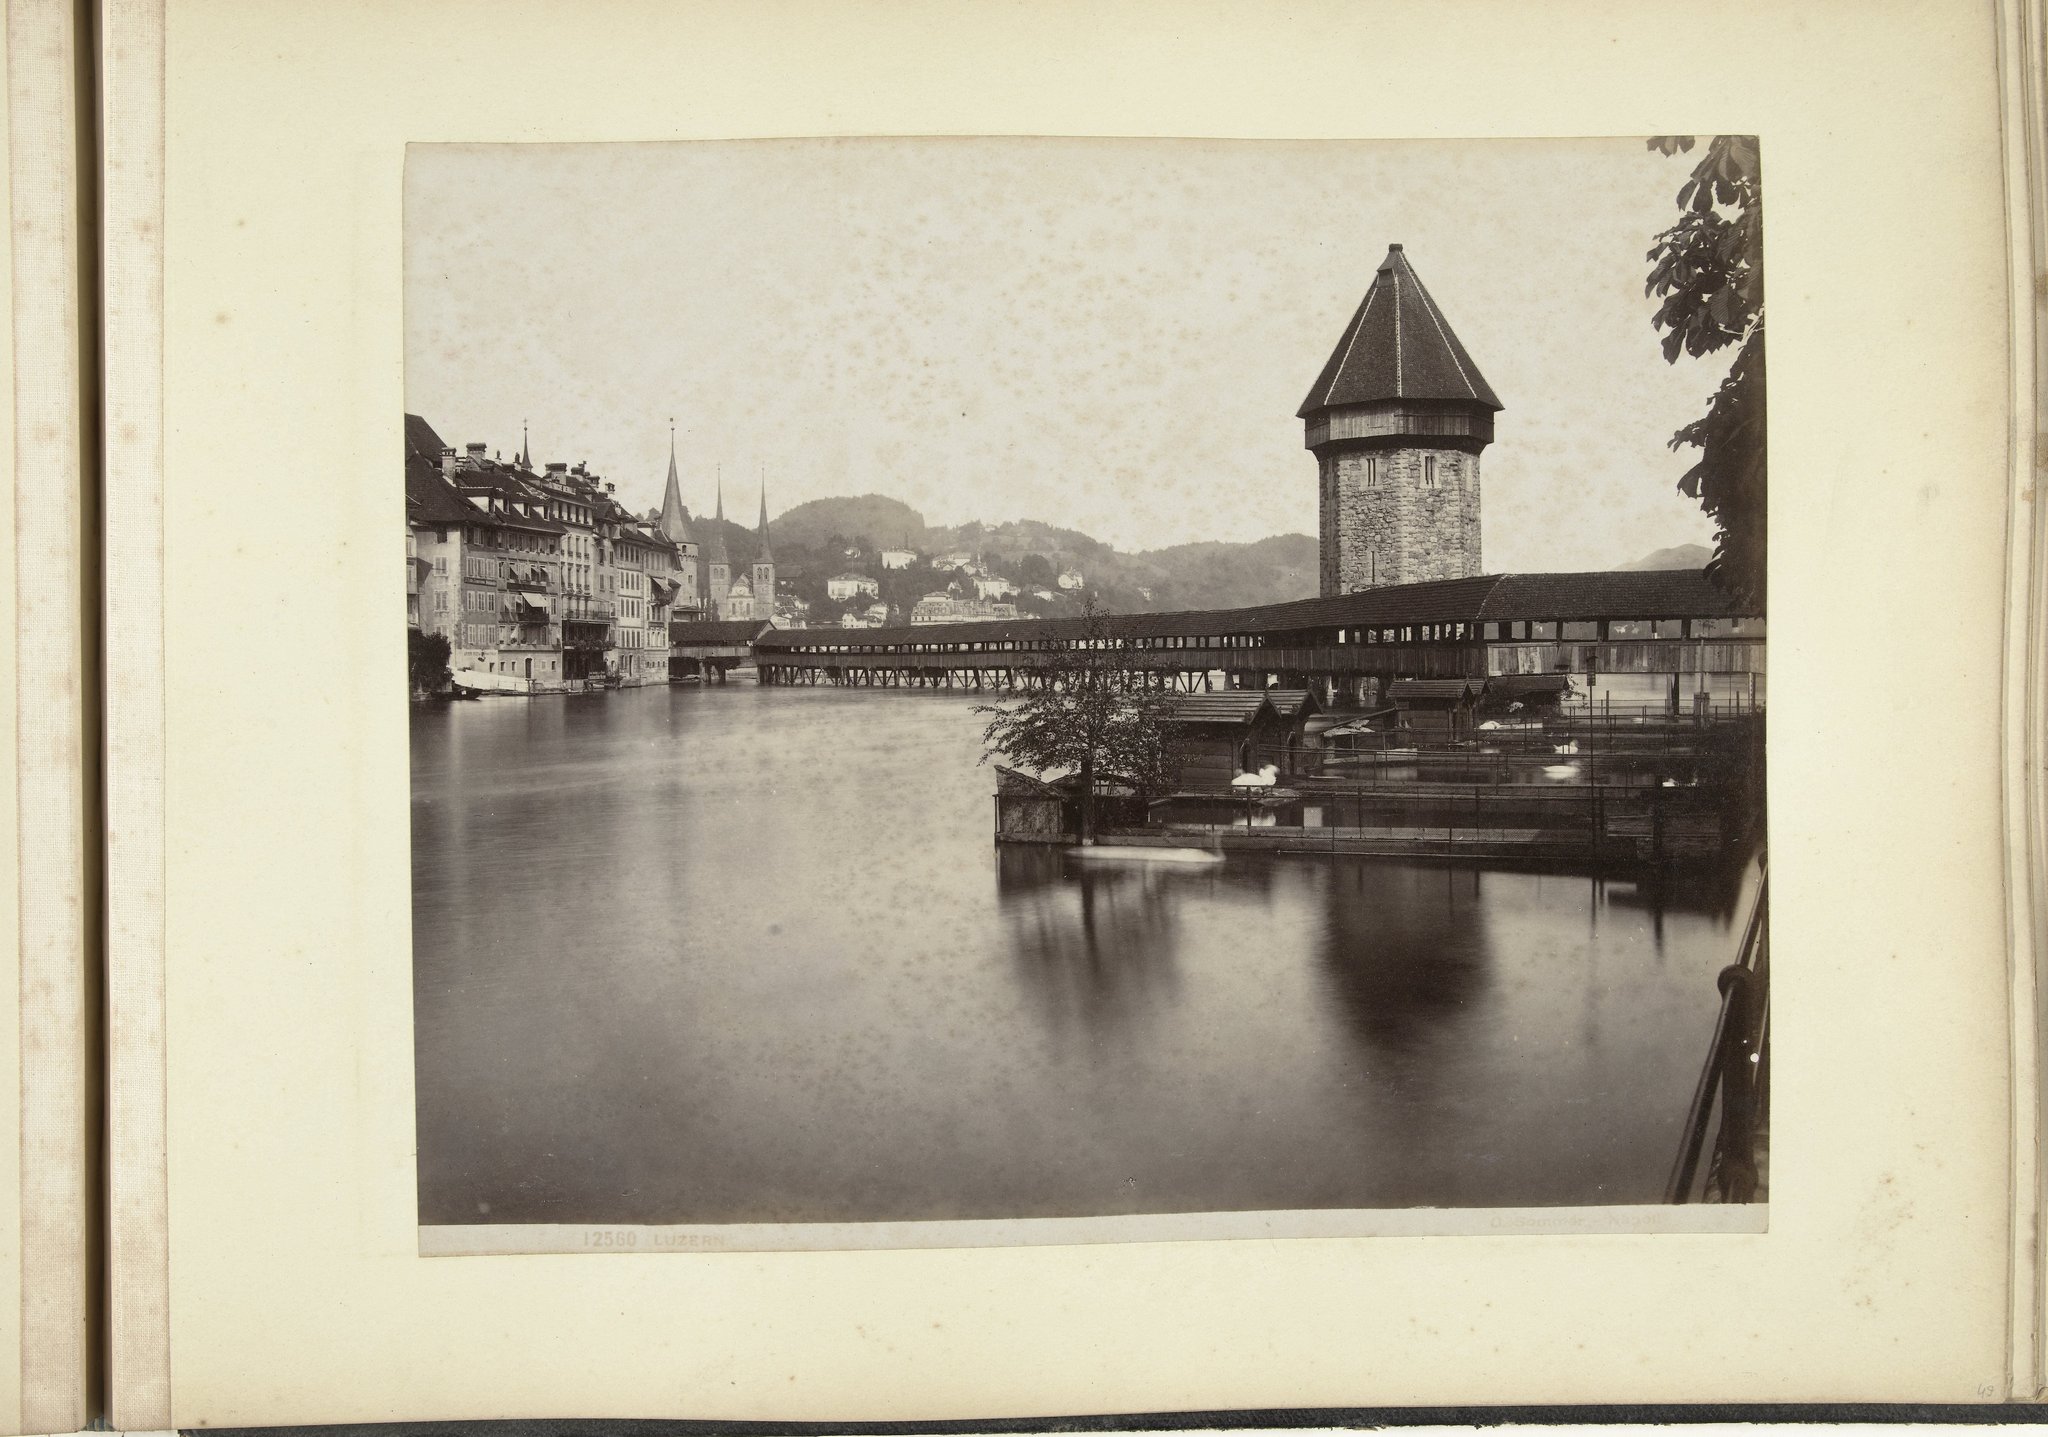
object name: photograph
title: Kapelbrug over de Reuss in Luzern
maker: giorgio sommer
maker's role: fotograaf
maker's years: 1834-1914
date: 1881-1900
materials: paper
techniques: albumen print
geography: lucerne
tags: city-view in general; 'veduta', lake, bridge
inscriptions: number: ‘12560’